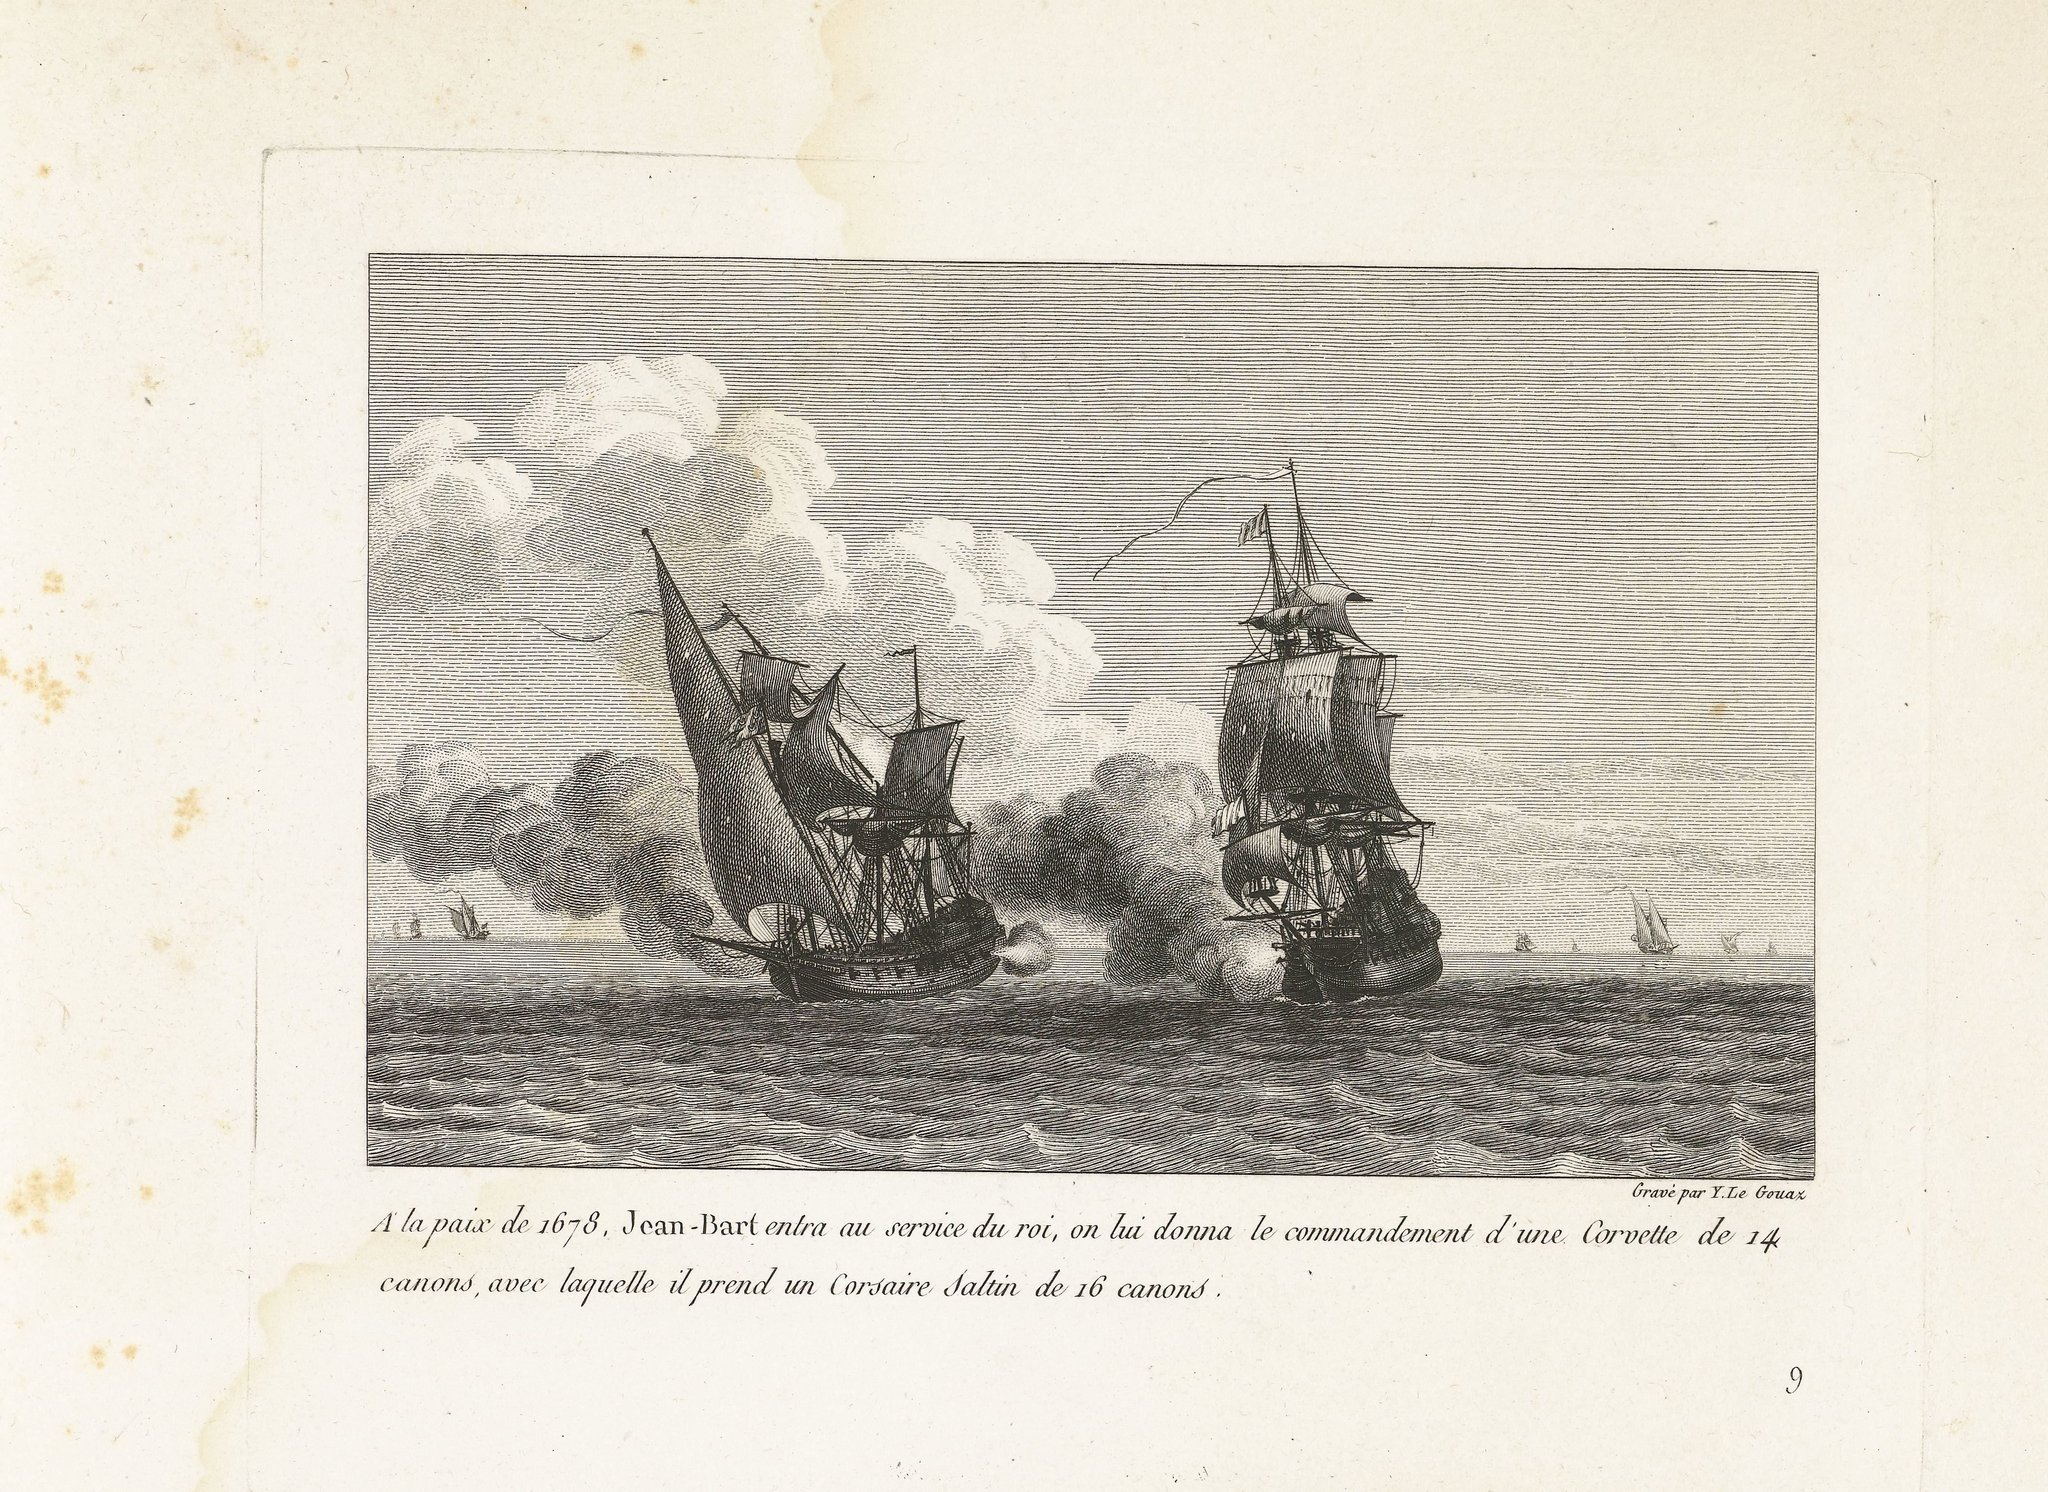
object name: history print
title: A la paix de 1678, Jean-Bart entra au service du roi, on lui donna le commandement d'une Corvette de 14 canons, avec laquelle il prend un Corsaire Saltin de 16 canons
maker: yves marie le gouaz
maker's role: print maker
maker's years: 1742-1816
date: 1806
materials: paper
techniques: etching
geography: paris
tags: battle (+ naval force)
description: Na de vrede in 1678 komt Jan Bart in dienst van de koning van Frankrijk. Onderdeel van een serie over de daden van de Vlaamse kaper in Franse dienst Jan Bart.